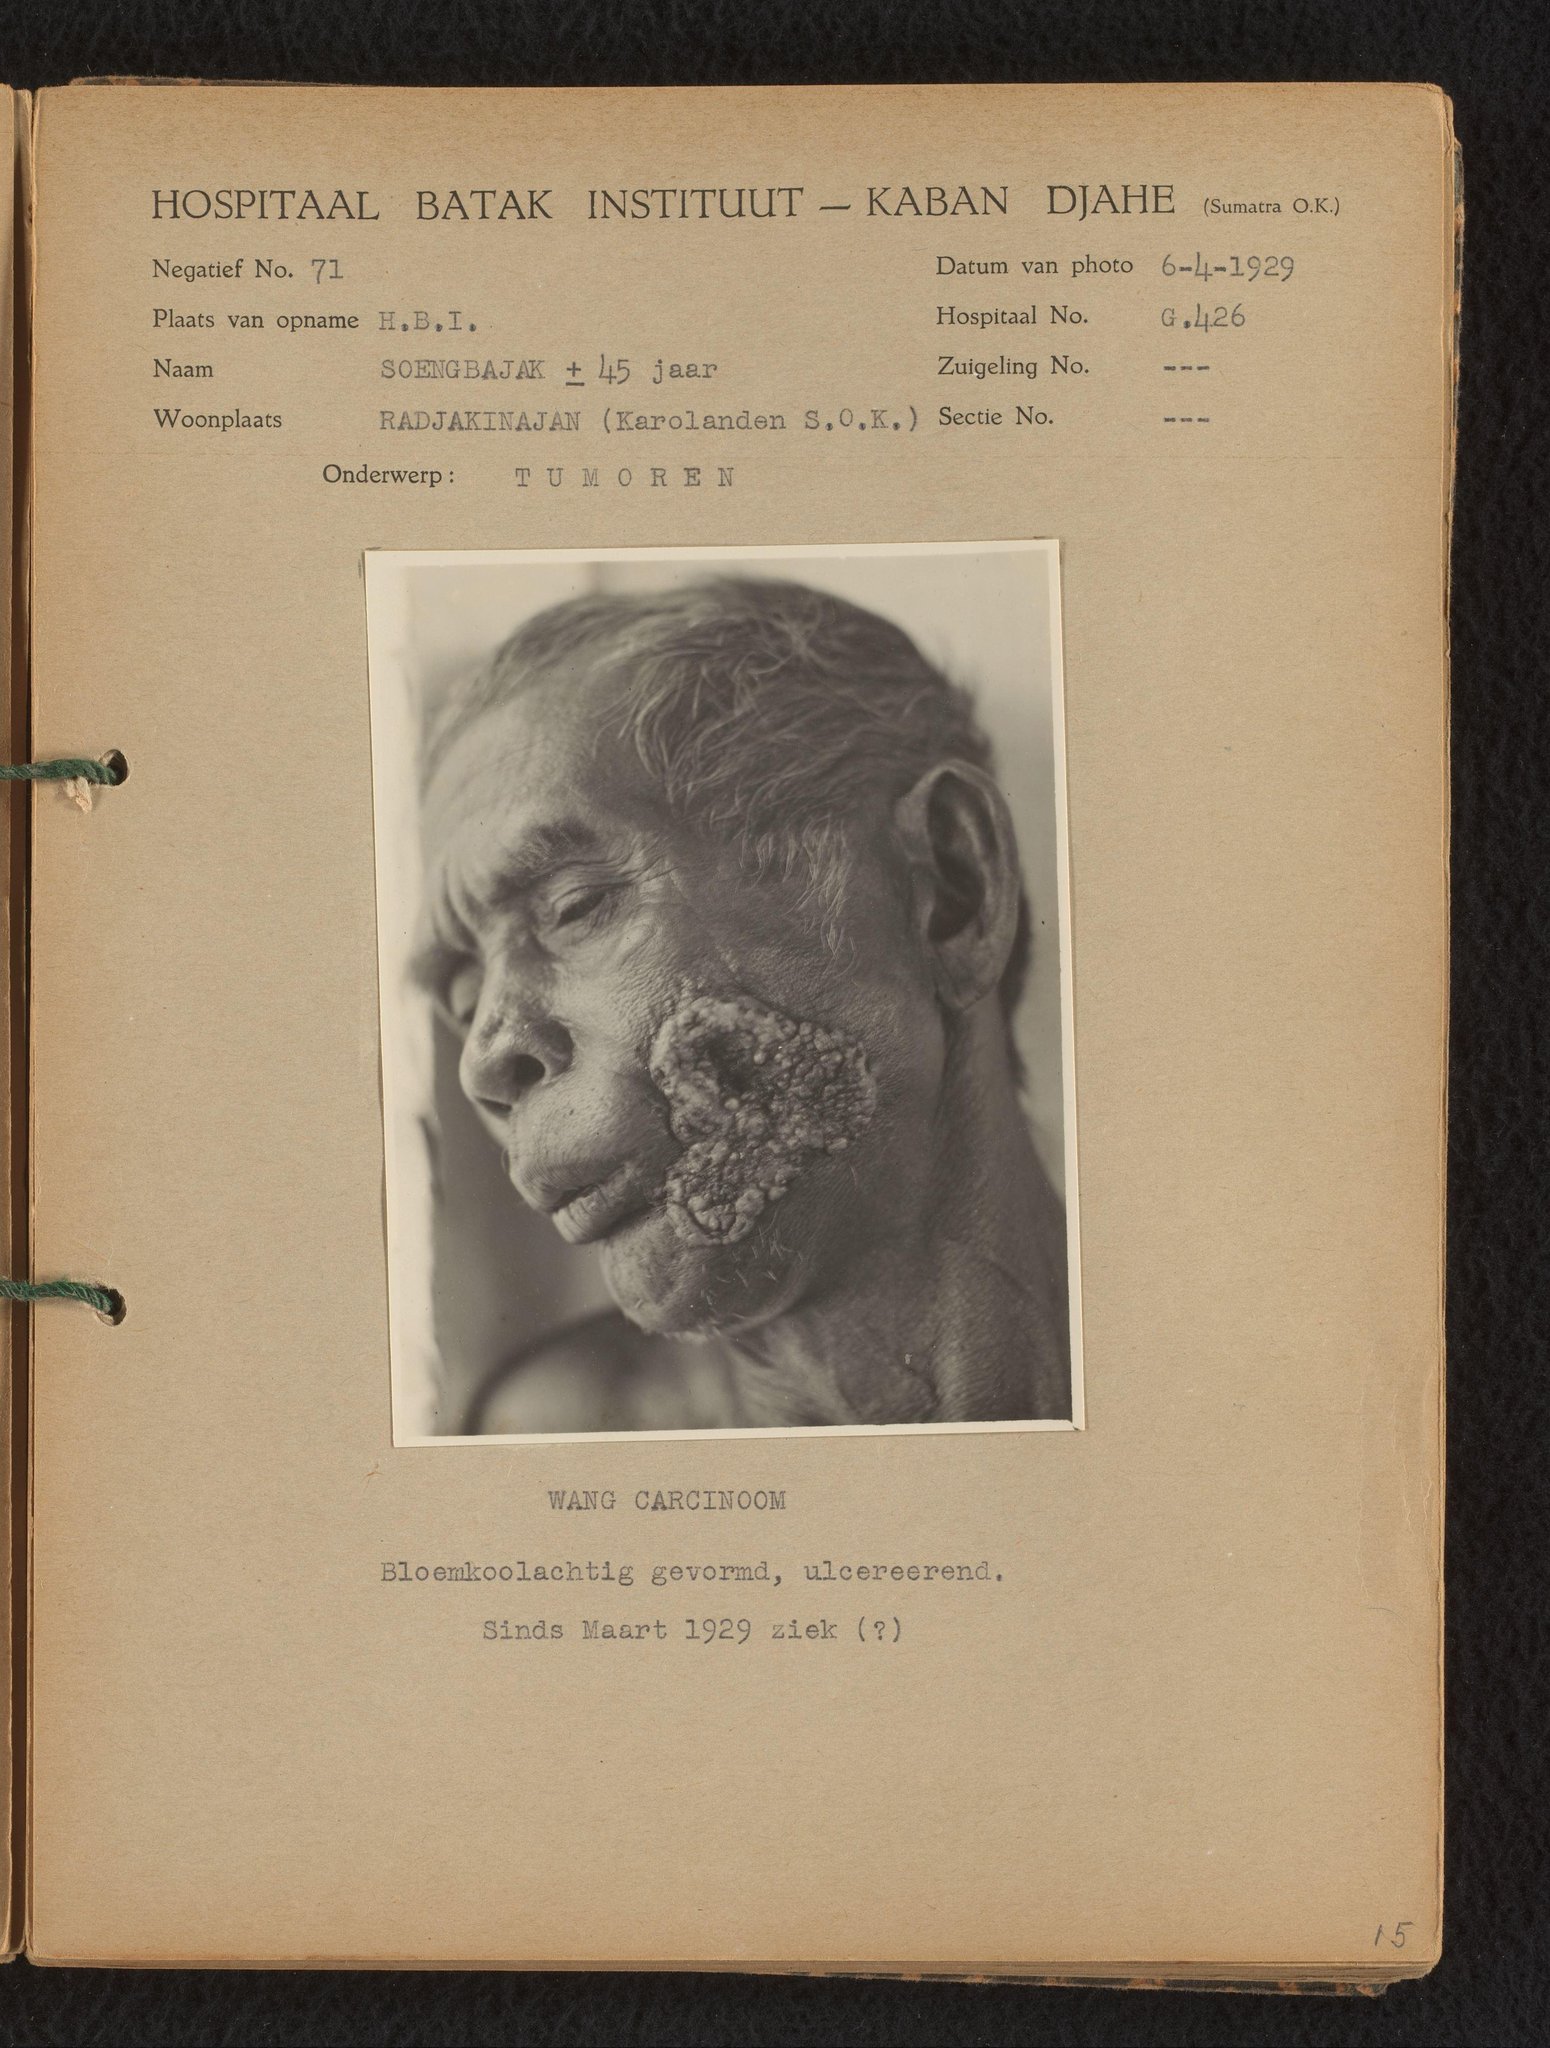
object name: photograph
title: Wang carcinoom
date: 1929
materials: cardboard, photographic support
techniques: gelatin silver print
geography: kabanjahe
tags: colonial system, external tumours, patient, sick person, sumatra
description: Medische foto van een man genaam Soengbajak van ca. 45 jaar met de tumor in de wang. Datum foto: 6 april 1929. Foto geplakt op voorgedrukt kartonnen blad ingebonden in het fotoalbum over het Hospitaal Batak Instituut te Kabanjaheh op Sumatra in de jaren 1926-1929.